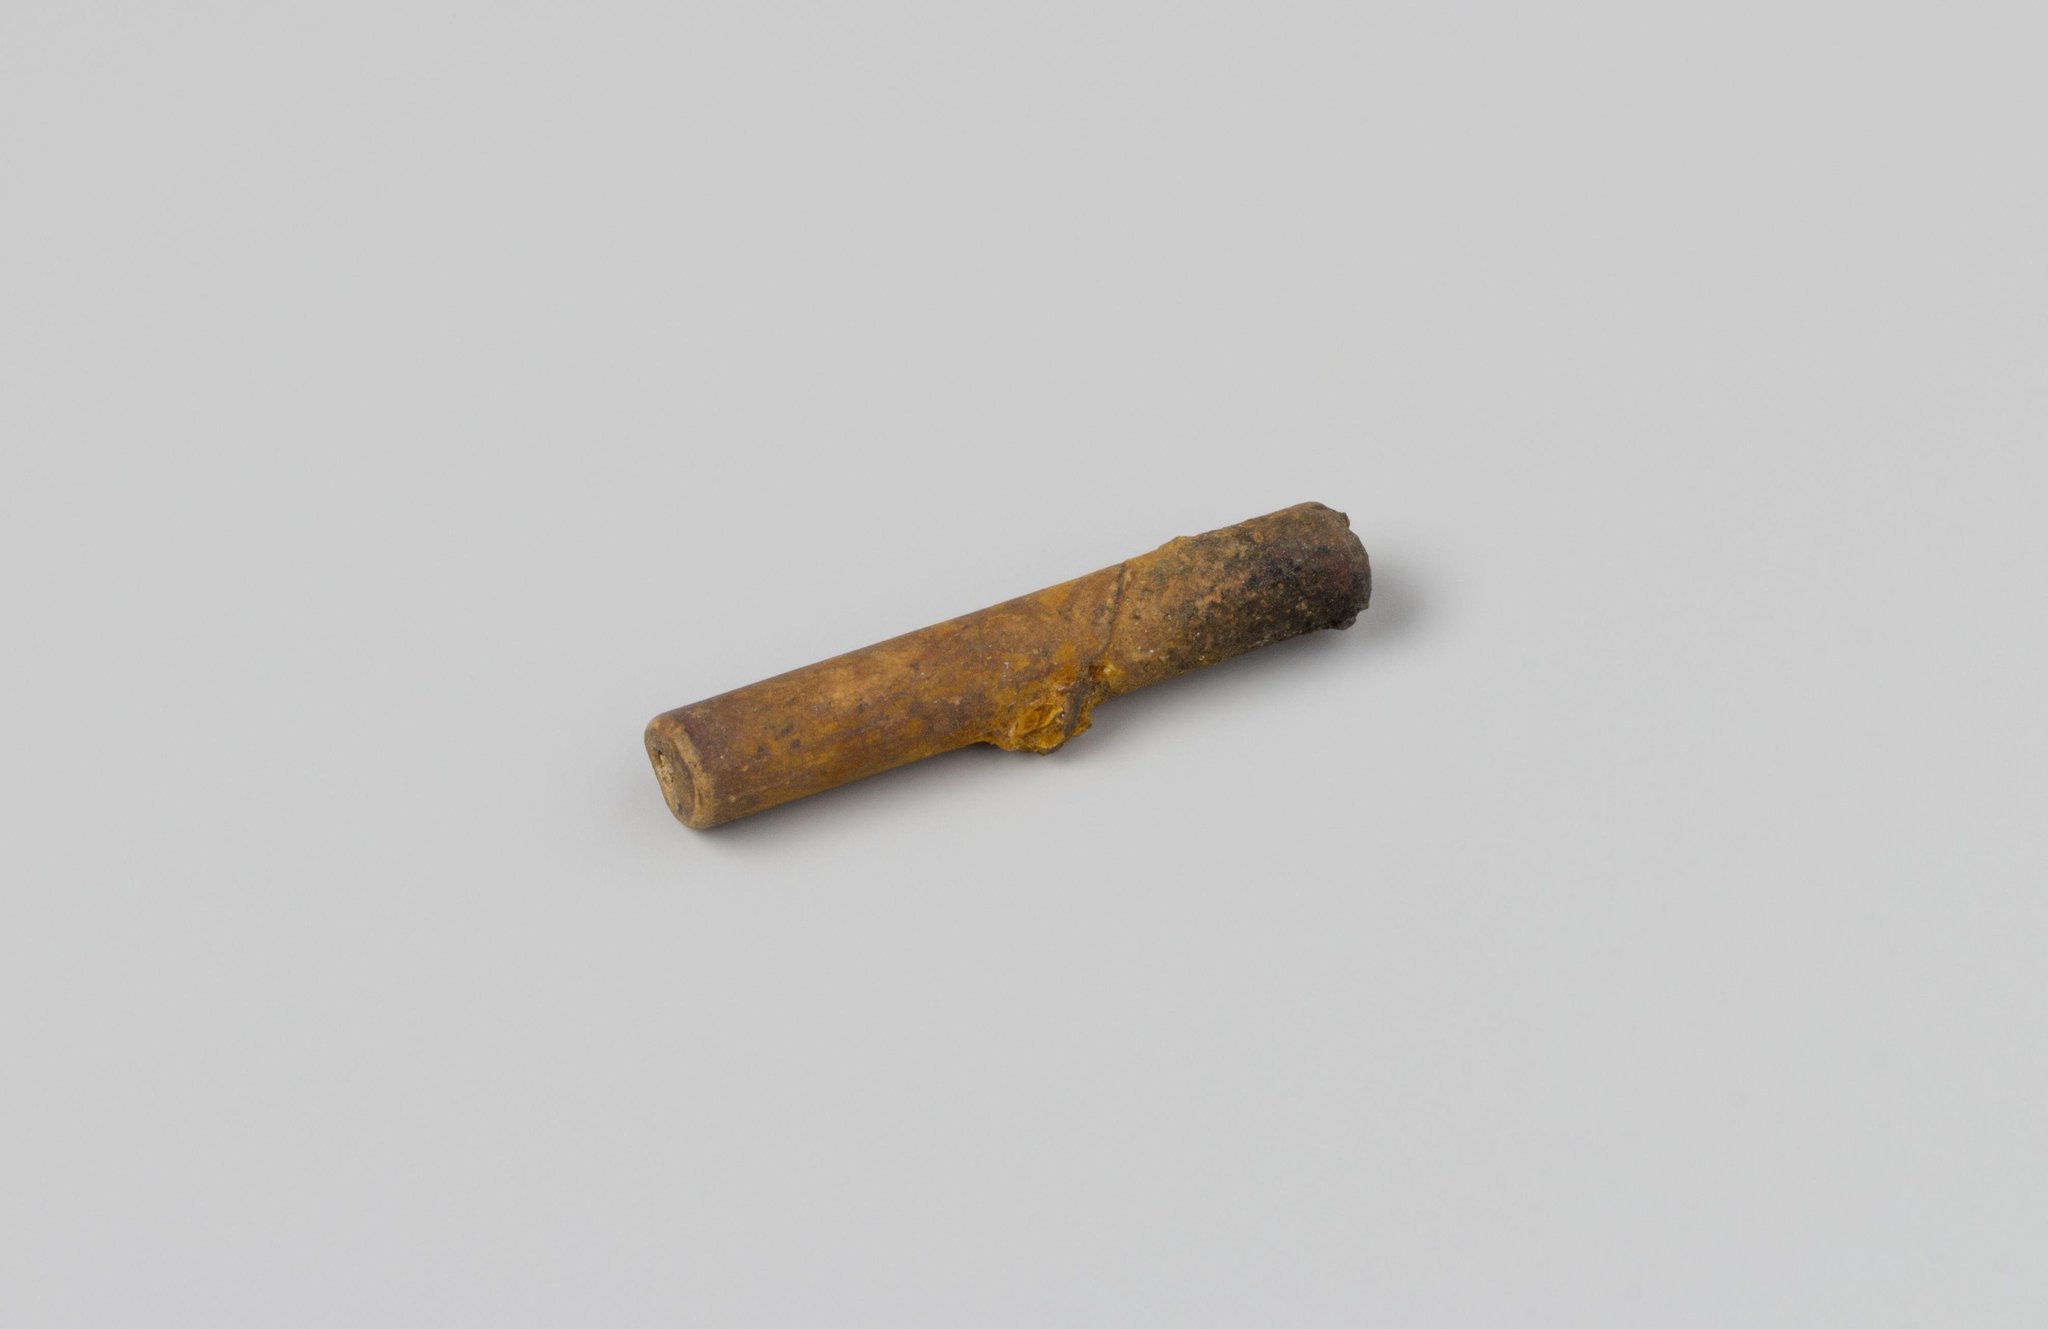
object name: pipe stem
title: Fragment pijpensteel uit het wrak van de Oost-Indiëvaarder Hollandia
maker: Anonymous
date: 1700-1743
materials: clay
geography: netherlands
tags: verenigde oostindische compagnie, hollandia (schip), annet